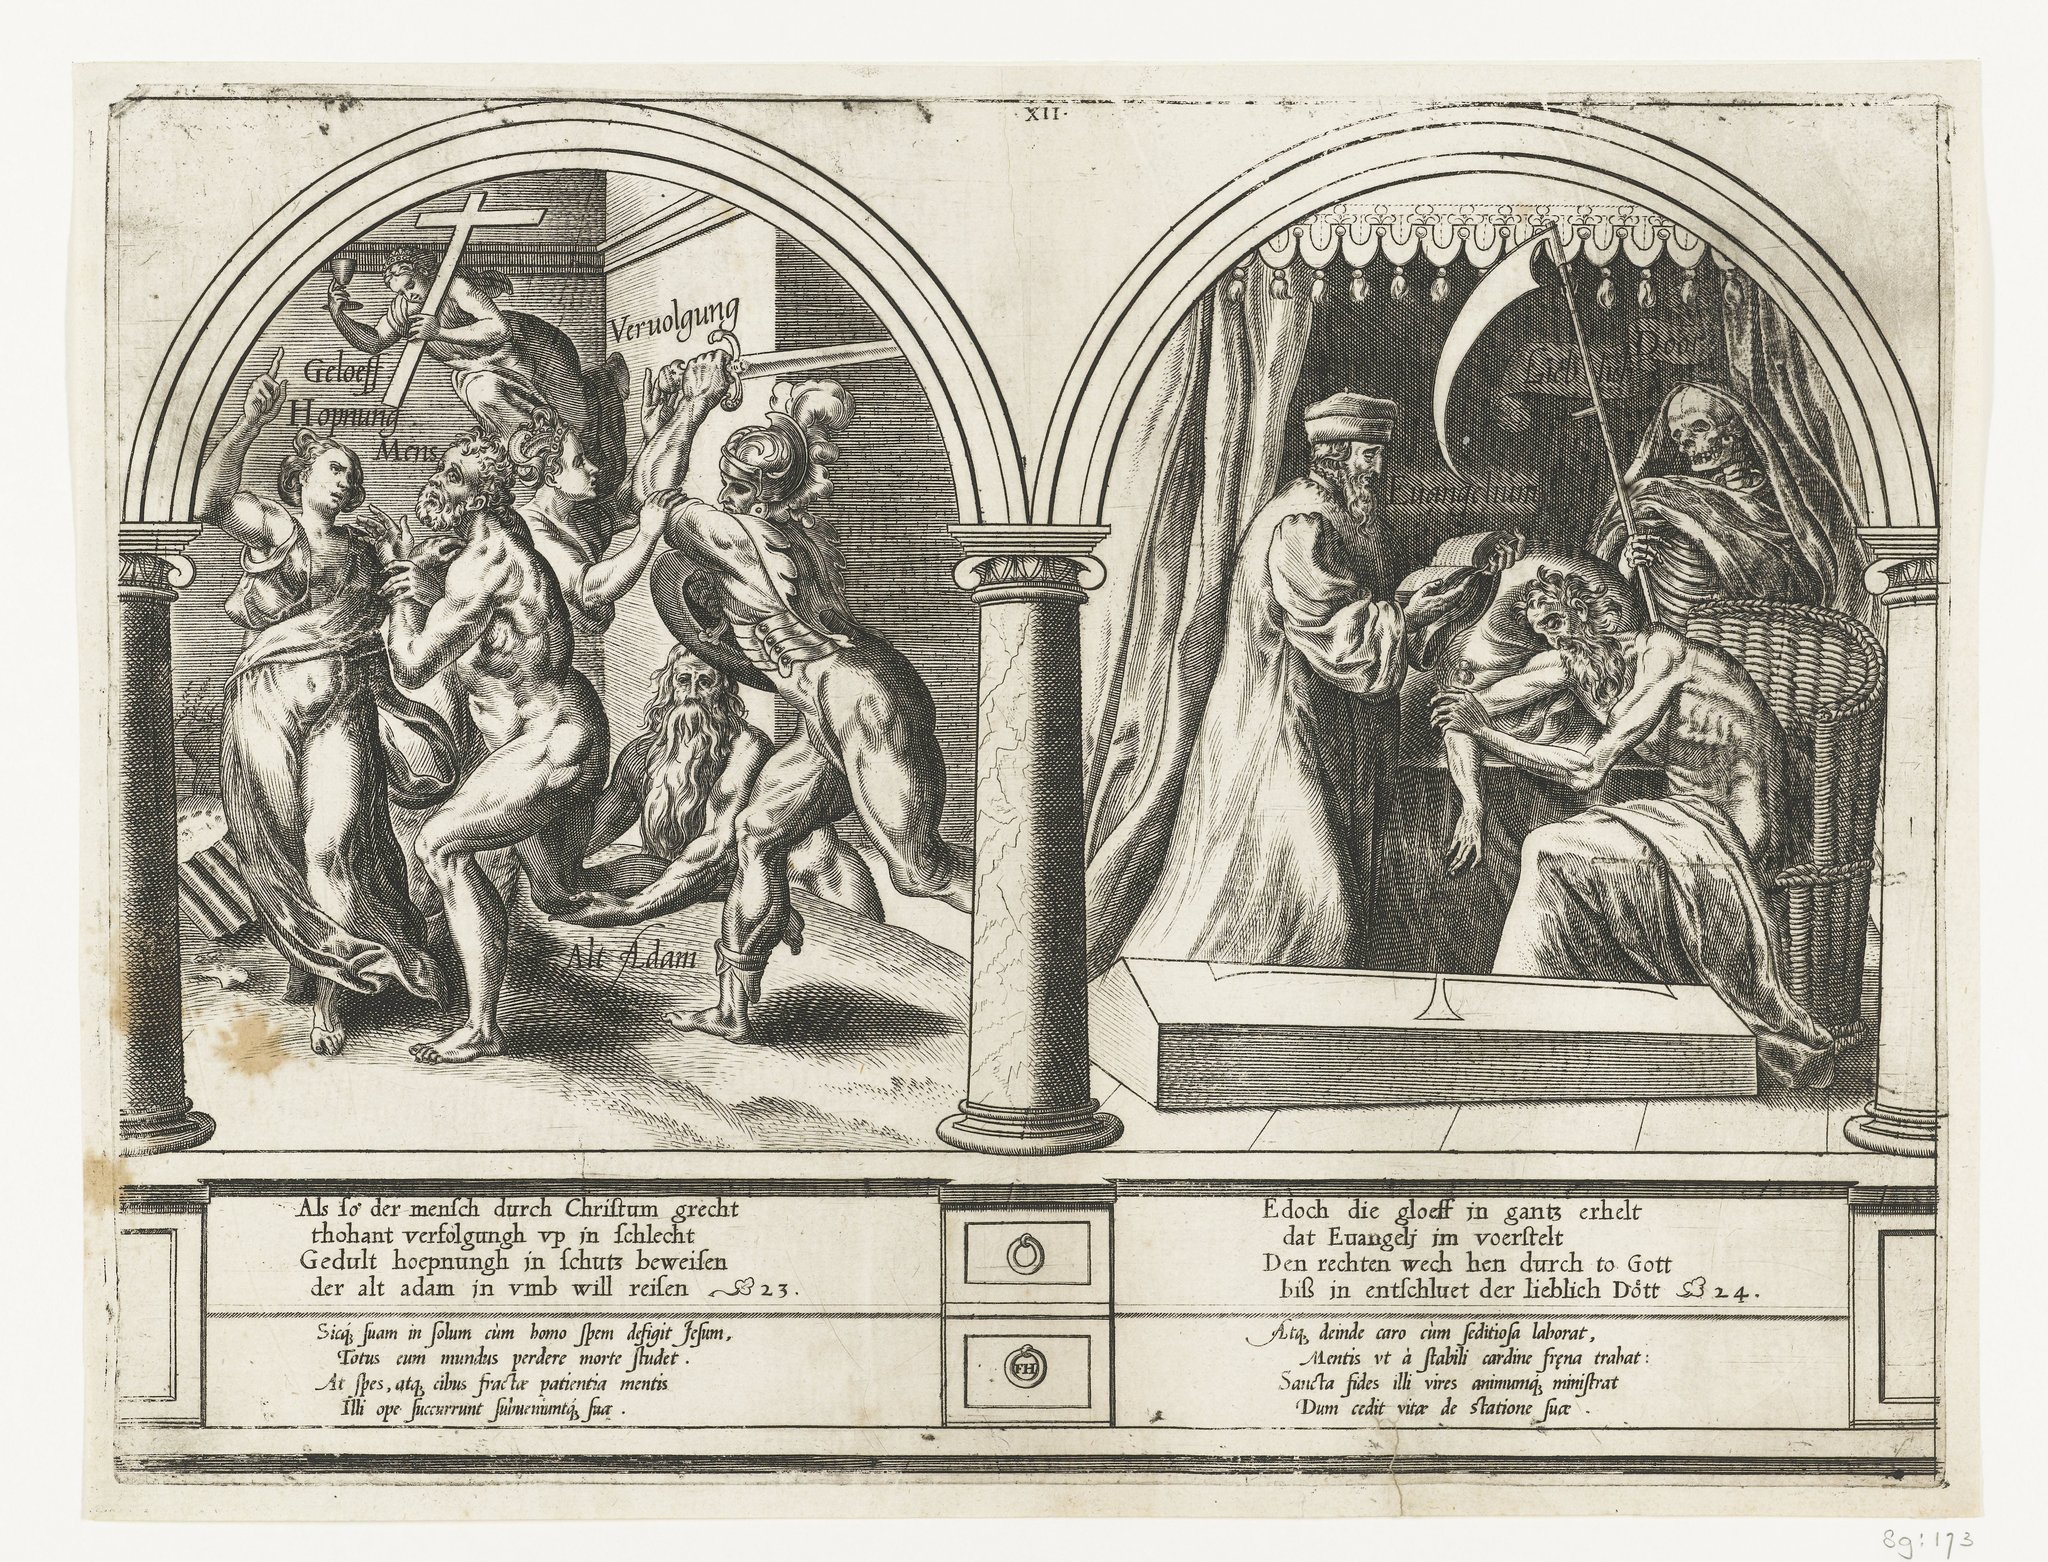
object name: print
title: Heilsweg van de mens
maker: frans huys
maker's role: print maker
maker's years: 1522-1562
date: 1546-1562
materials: paper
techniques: engraving, etching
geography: antwerp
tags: faith, 'fides'; 'fede', 'fede catholica', 'fede christiana', 'fede christiana catholica' (ripa) ~ one of the three theological virtues, hope, 'spes'; 'speranza divina e certa' (ripa) ~ one of the three theological virtues, death as skeleton (+ death with scythe), patience; 'patienza' (ripa), doctrine on original sin, and redemption, adam (not in biblical context) - (other) specific aspects, e.g. allegorical and symbolical aspects of male persons from the old testament (not in biblical context)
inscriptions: collector's mark: Lugt 2228, collector's mark: Lugt 2760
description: Twee bijbelse allegorieën in architecturale omlijsting. Links de Mens, die door de personificaties van Geloof, met kruis en kelk, Hoop, omhoog wijzende, en Geduld wordt geholpen. De personificatie van Vervolging, met een zwaard, wordt tegengehouden door Geduld. De Mens wordt aan zijn been getrokken door de Oude Adam, zijn oude zondige aard. Rechts sterft de Mens de Liefelijke Dood, die achter hem staat als skelet met zeis. Naast de Mens staat een predikant, die hem uit het Evangelie voorleest. Op de voorgrond een doodskist. De voorstelling verbeeldt hoe de mens wordt behouden door het geloof. Onder beide voorstellingen een vierregelig vers in het Nederduits en een vierregelige tekst in het Latijn. Nummer 23 en 24 uit een reformatorische serie over de zondigheid en rechtvaardiging van de mens.